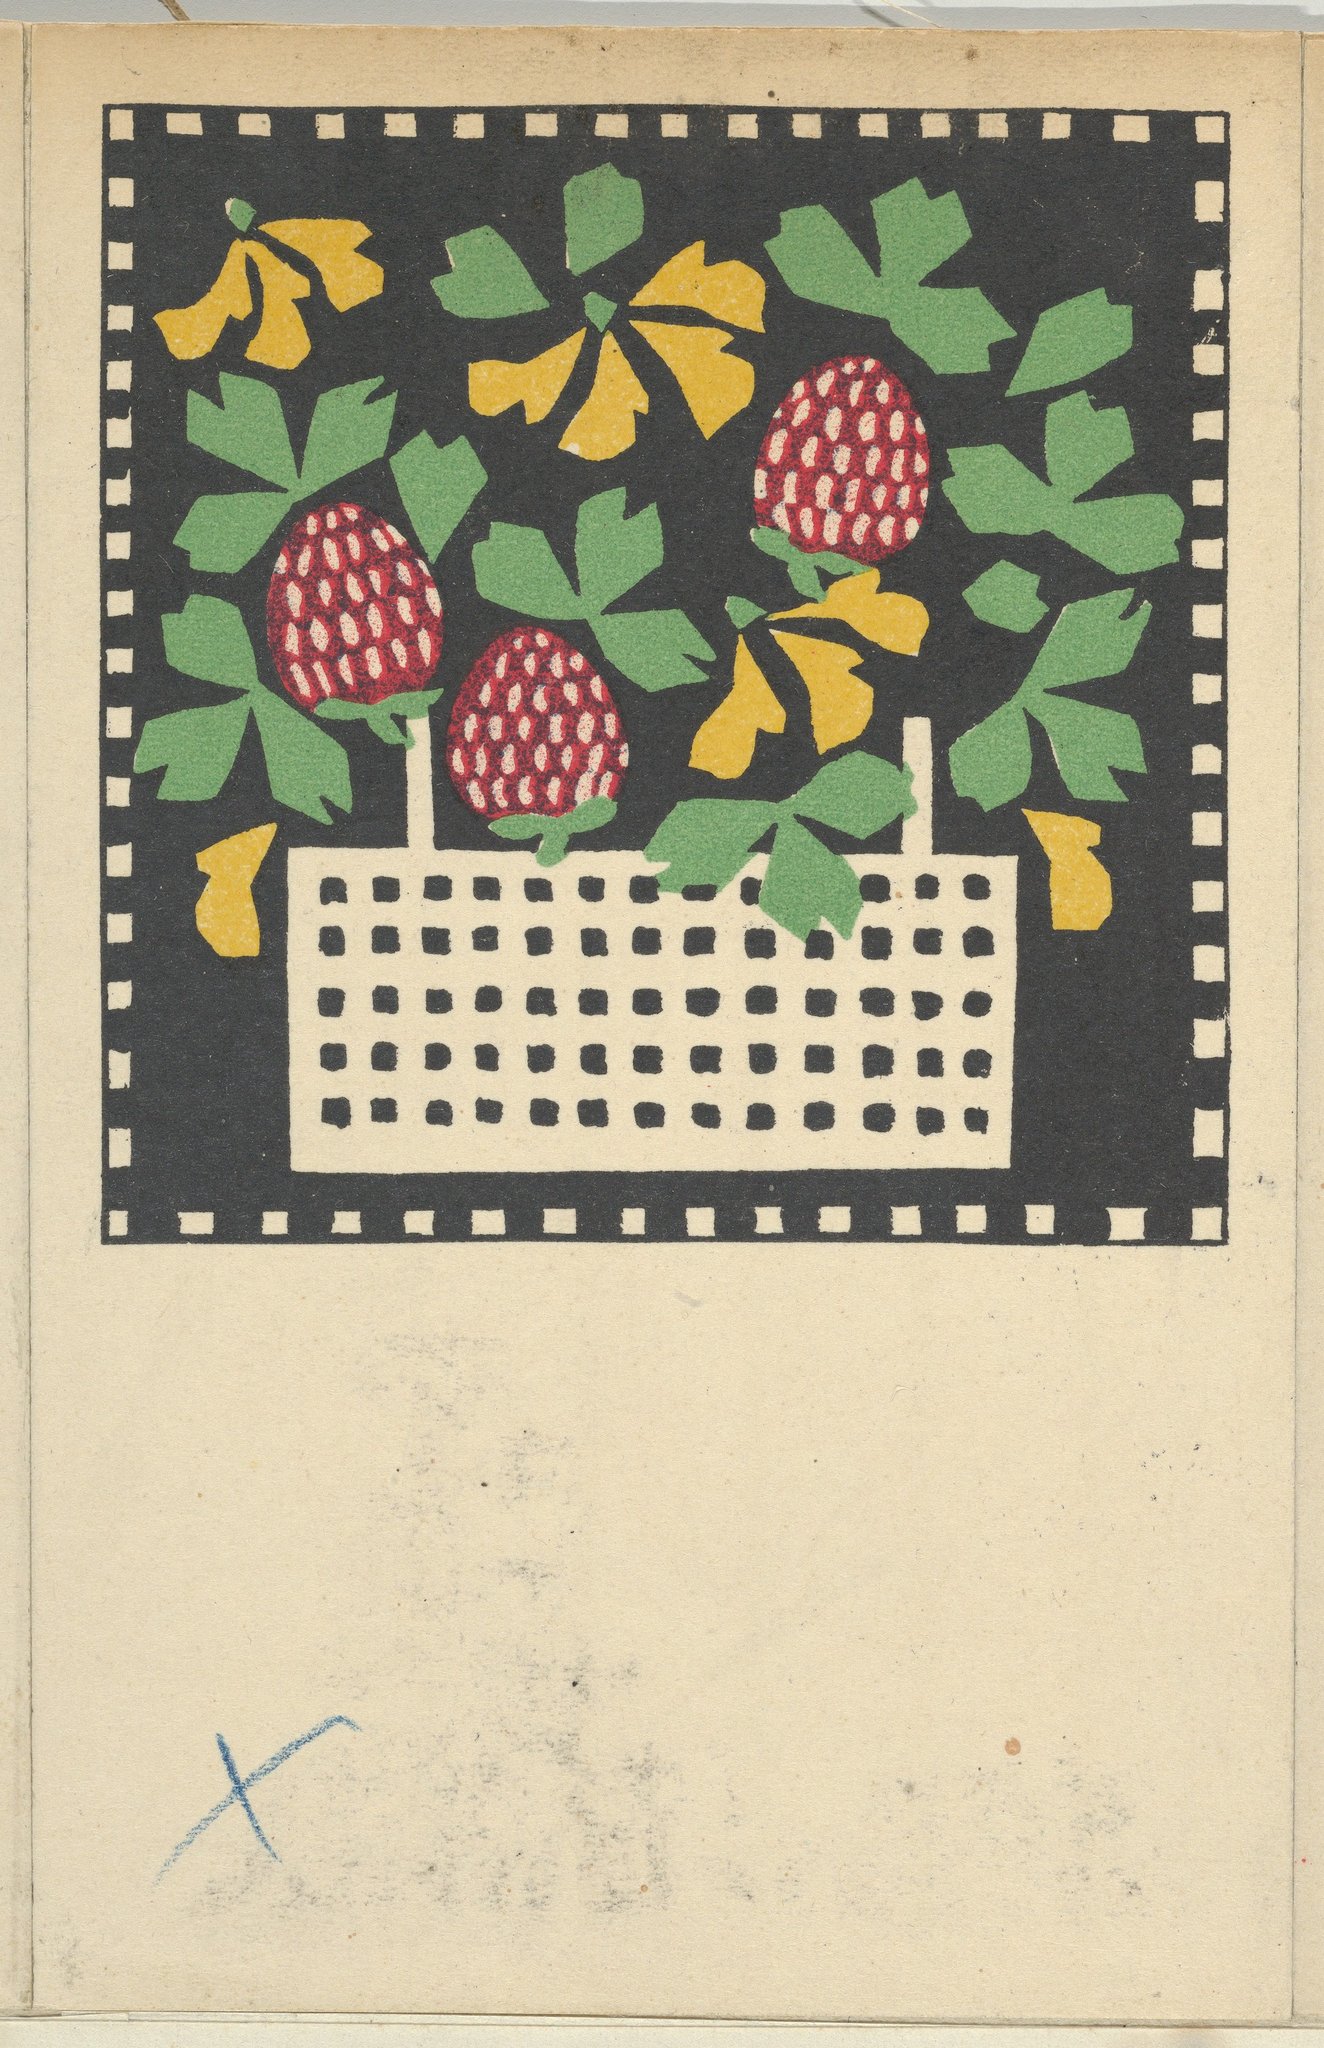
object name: print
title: Basket of Flowers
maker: leopoldine kolbe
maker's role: artist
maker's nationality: austrian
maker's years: 1870-1912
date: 1907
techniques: lithograph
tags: flowers